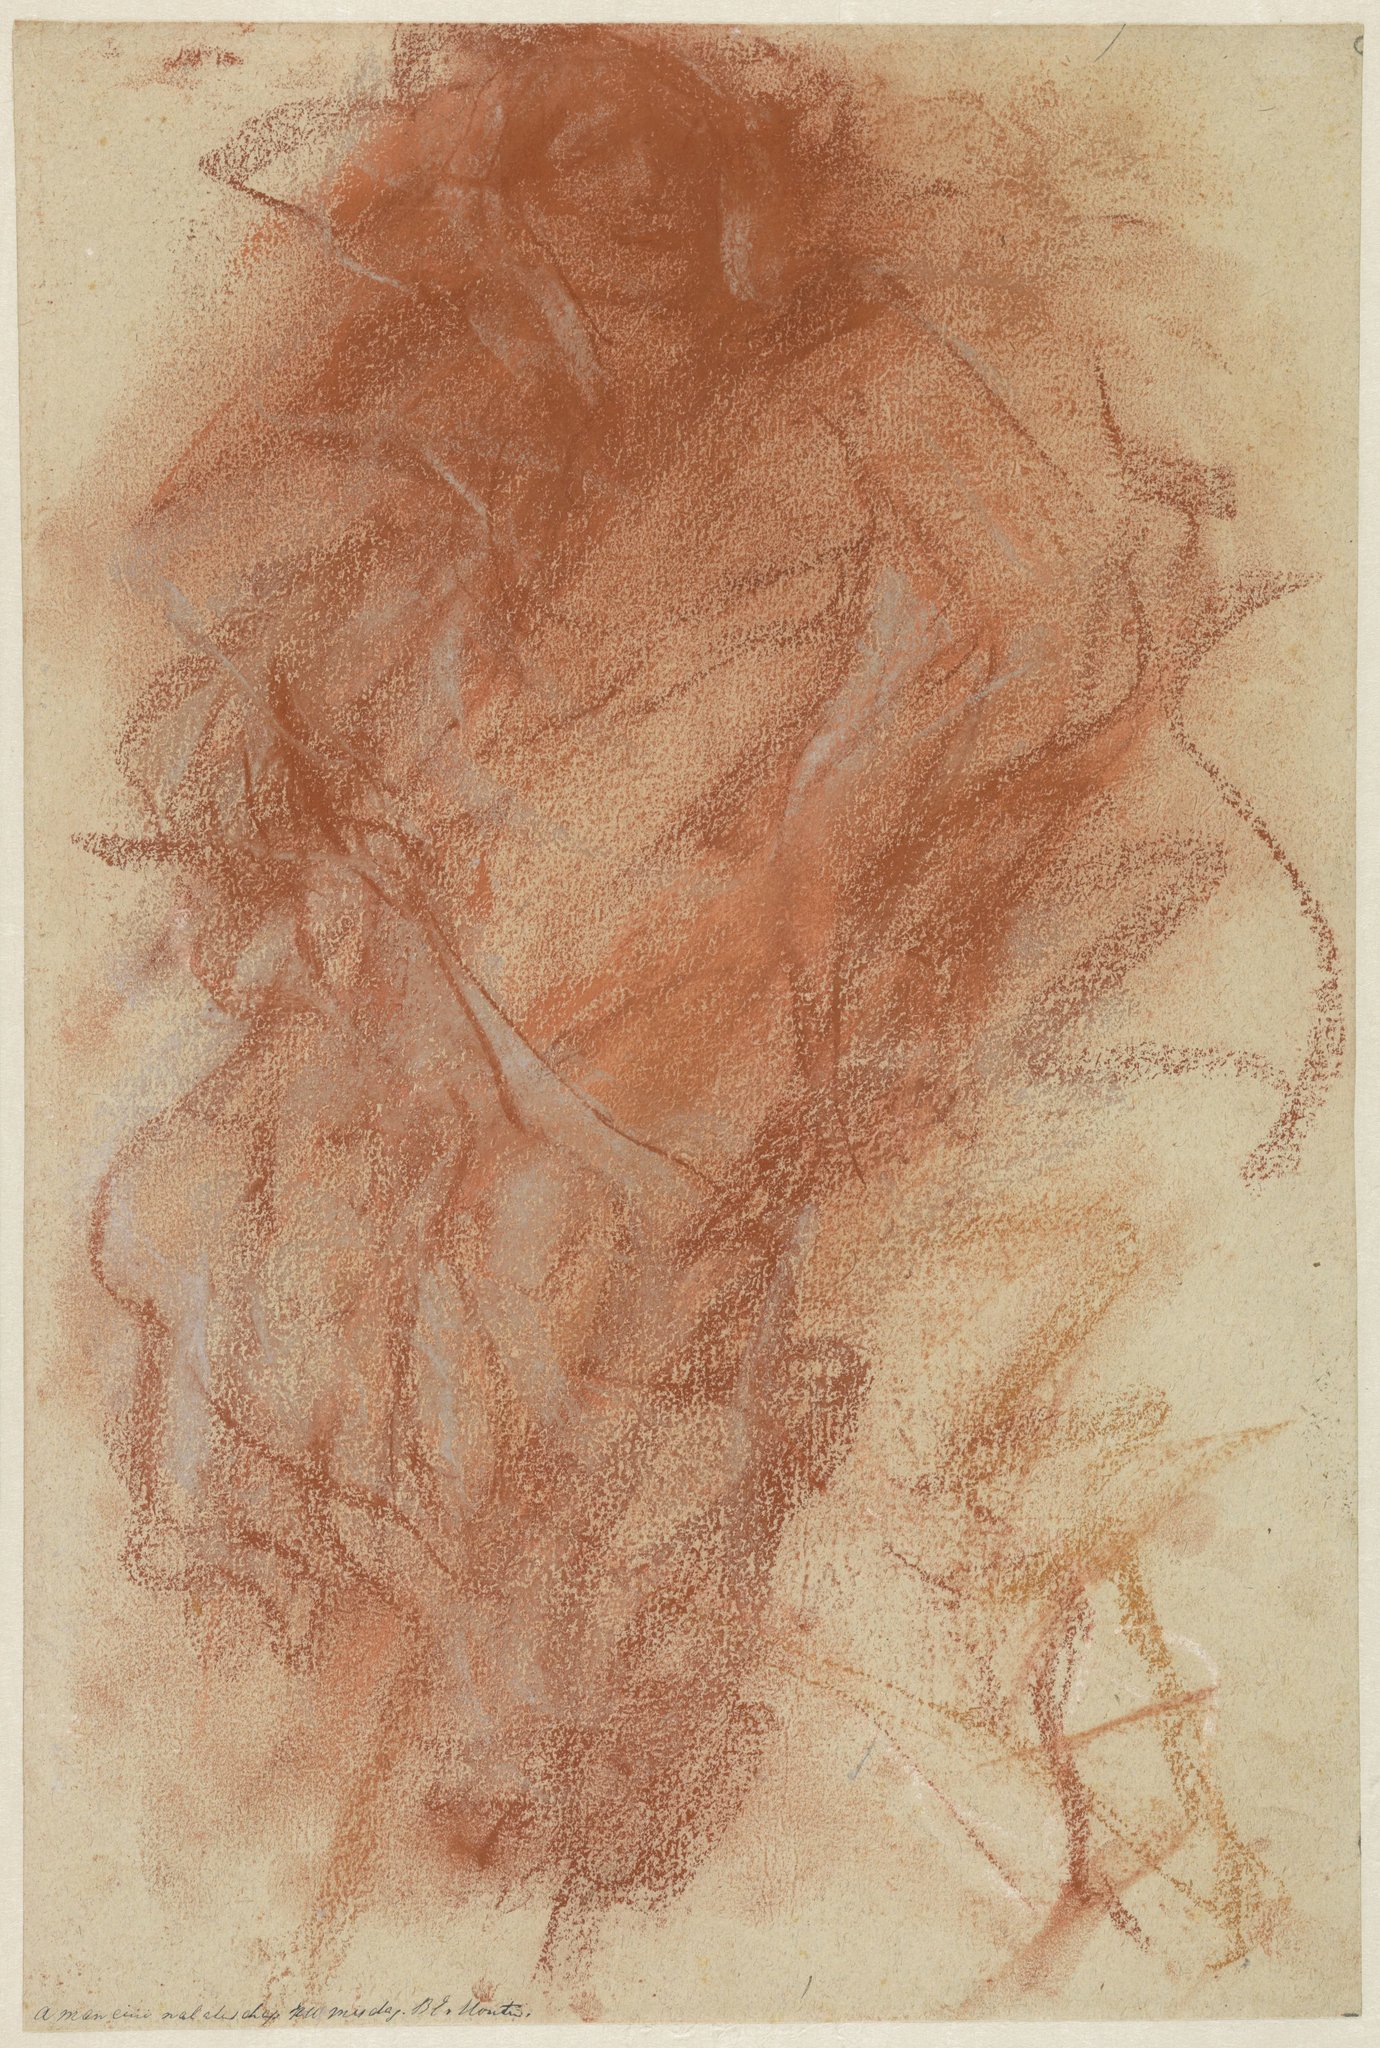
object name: drawing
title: Zittende vrouw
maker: antonio mancini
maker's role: draughtsman, painter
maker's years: 1852-1930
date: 1862-1930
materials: paper, pastel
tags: sitting figure - aa - female human figure